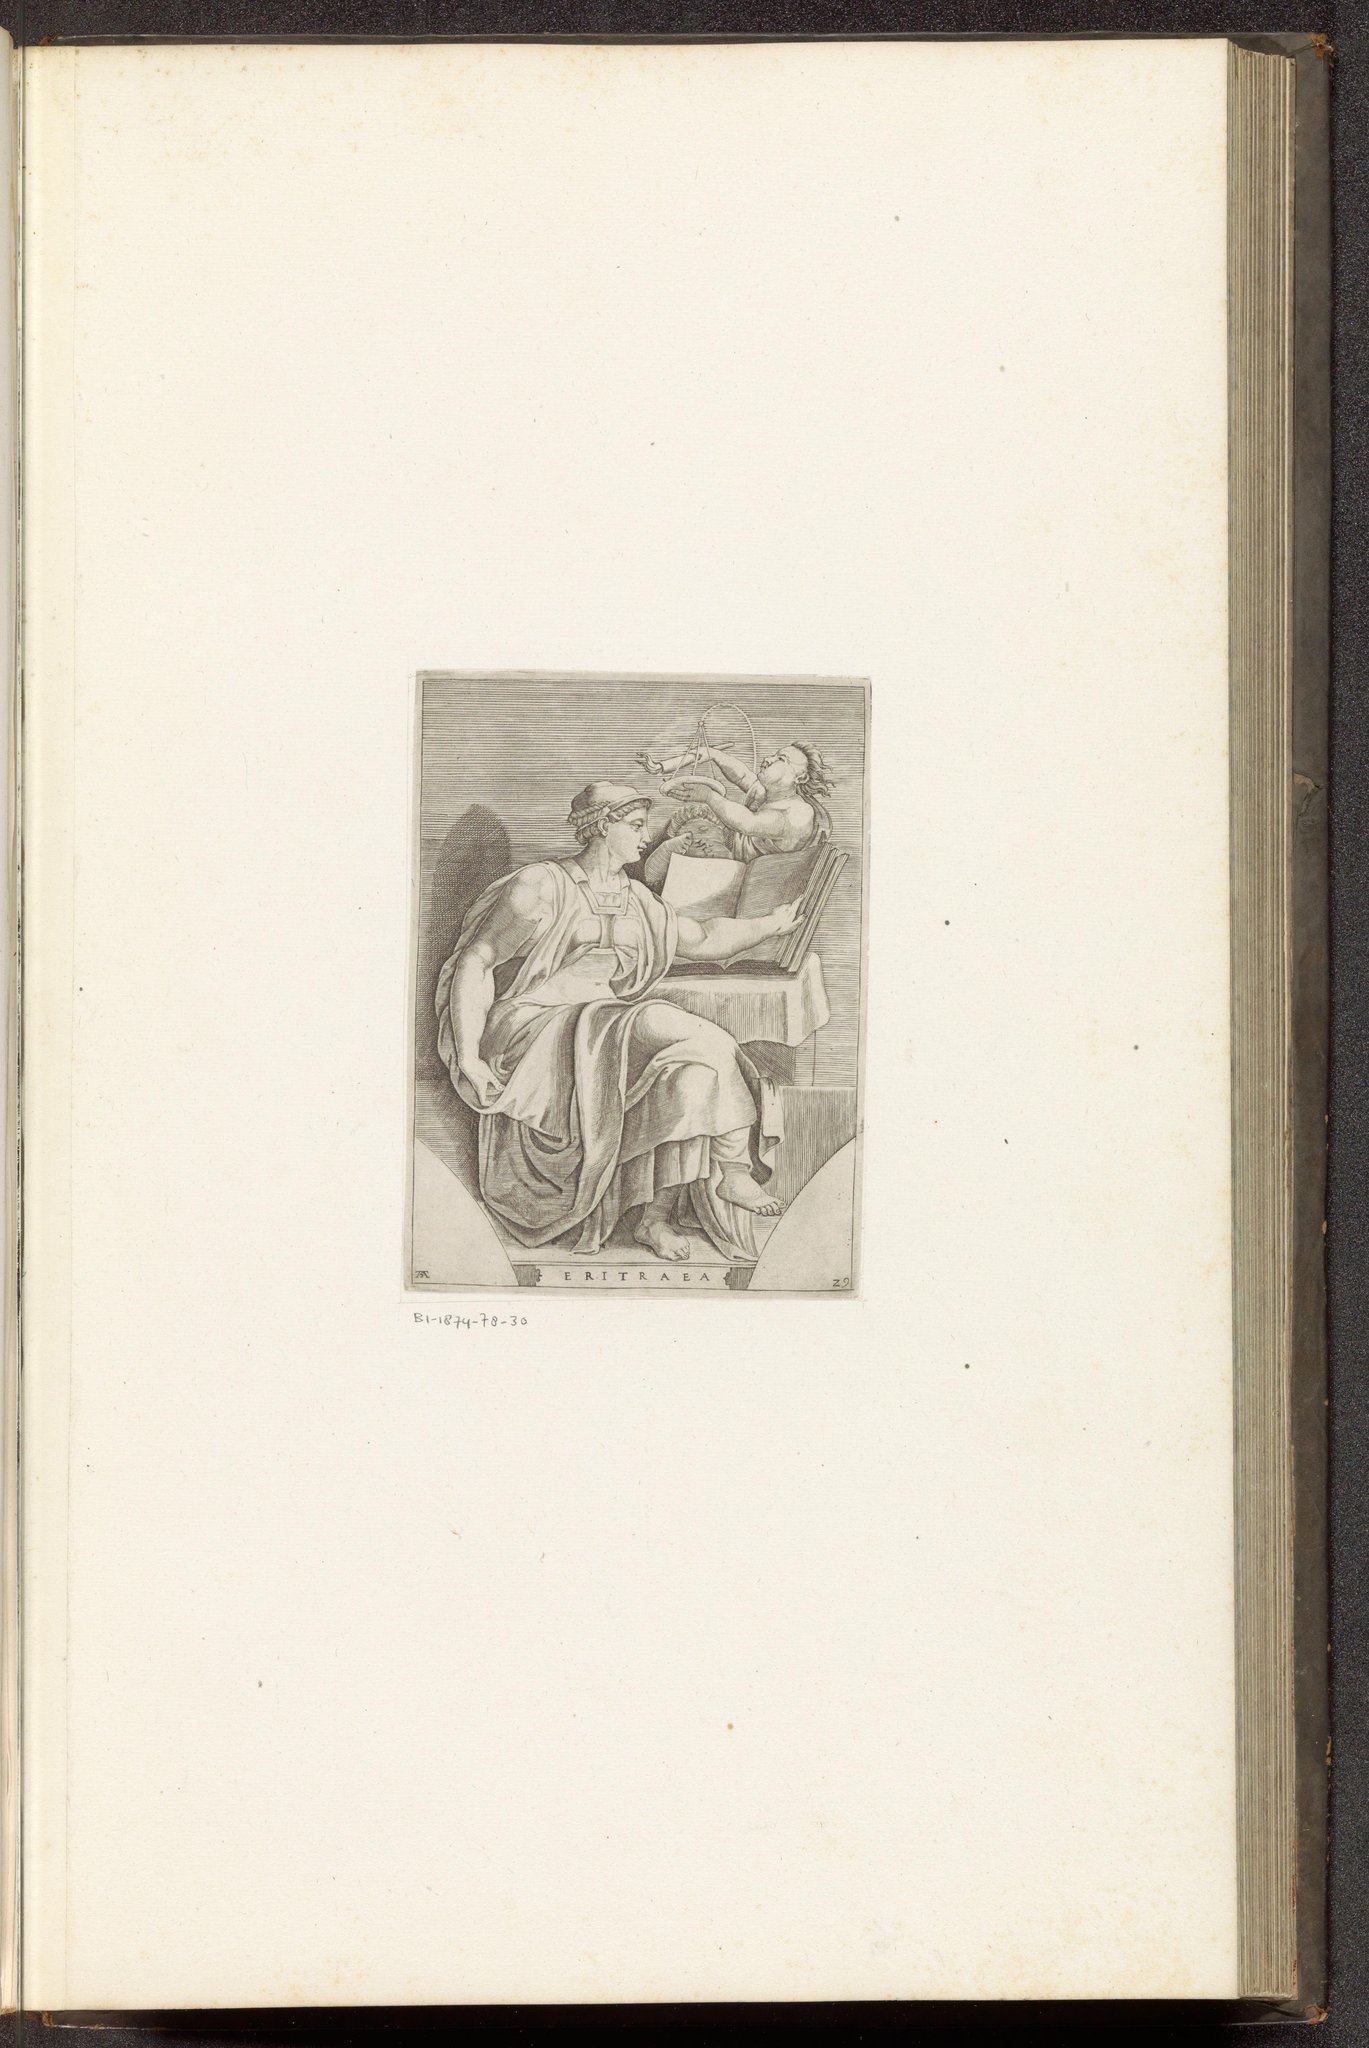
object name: print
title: Schilderingen in de Sixtijnse kapel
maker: adamo scultori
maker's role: painter, print maker, sculptor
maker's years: 1530-1585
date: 1585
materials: paper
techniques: engraving, intaglio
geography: vatican city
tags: erythraean sibyl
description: De Sibille van Erythrae met boek en naakte figuren. Eén van de Sibillen van Michelangelo's plafondschildering. Genummerd rechtsonder: 29. De prent maakt deel uit van een album.